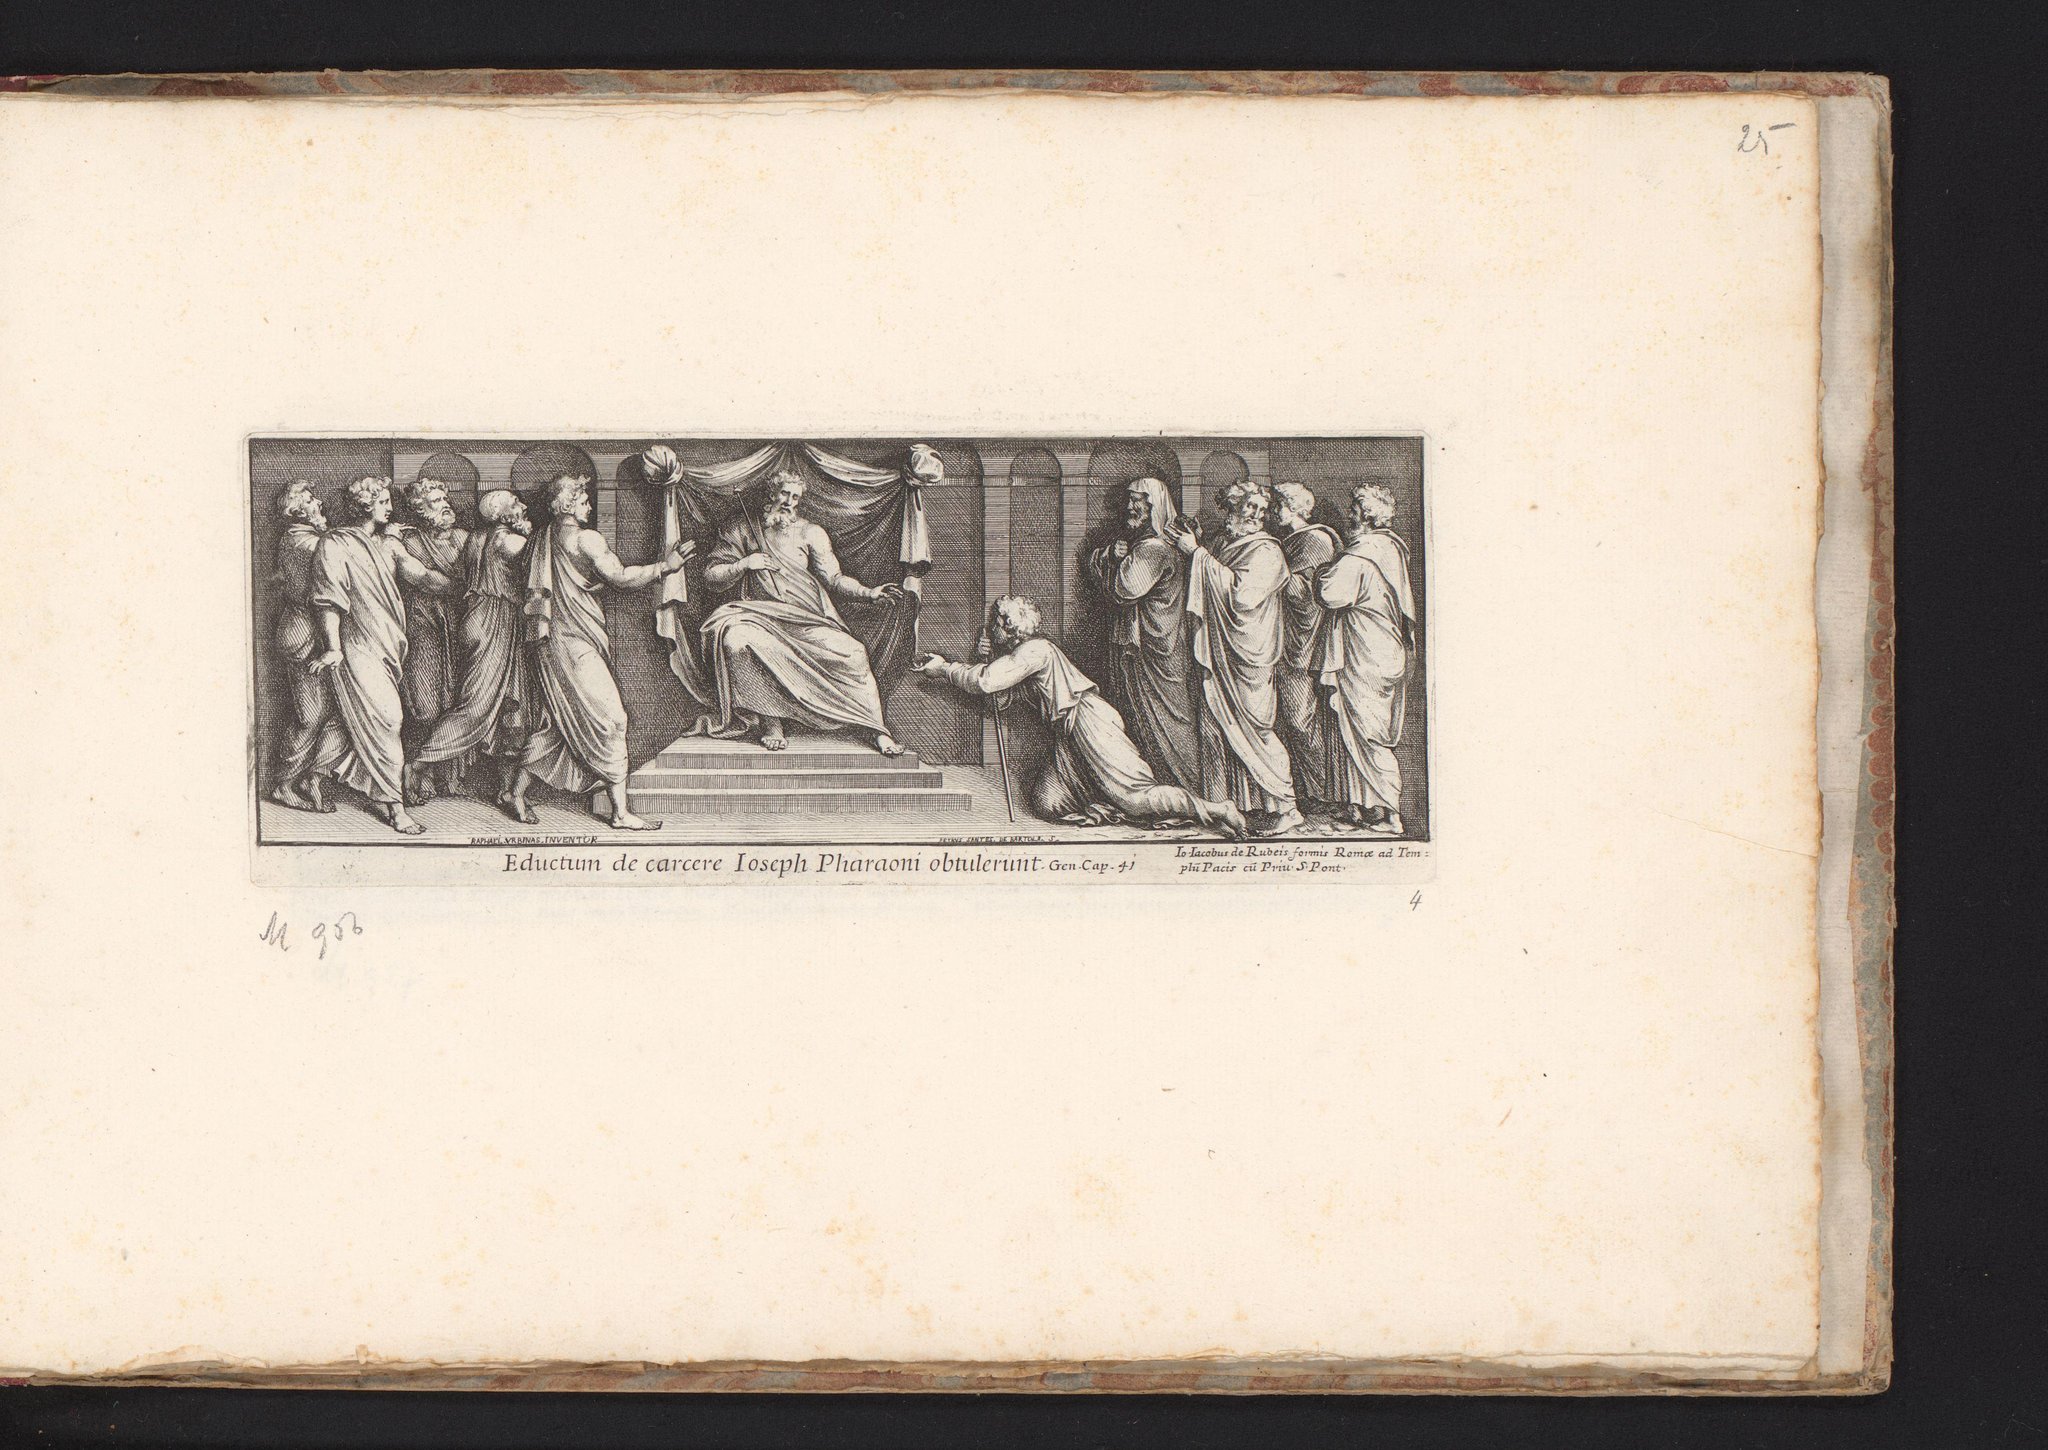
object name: album leaf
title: Voorstellingen door Rafaël in het Vaticaan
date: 1645-1700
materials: paper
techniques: engraving, etching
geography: italy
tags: story of joseph (part i)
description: Prent uit een reeks van 14 prenten (+ titelprent) naar schilderingen door Rafaël in de Stanze di Raffaello in het Apostolisch Paleis in het Vaticaan en naar ontwerpen voor wandtapijten voor de Sixtijnse Kapel door Rafaël. Naar een schildering door Rafaël in de Stanza di Eliodoro.